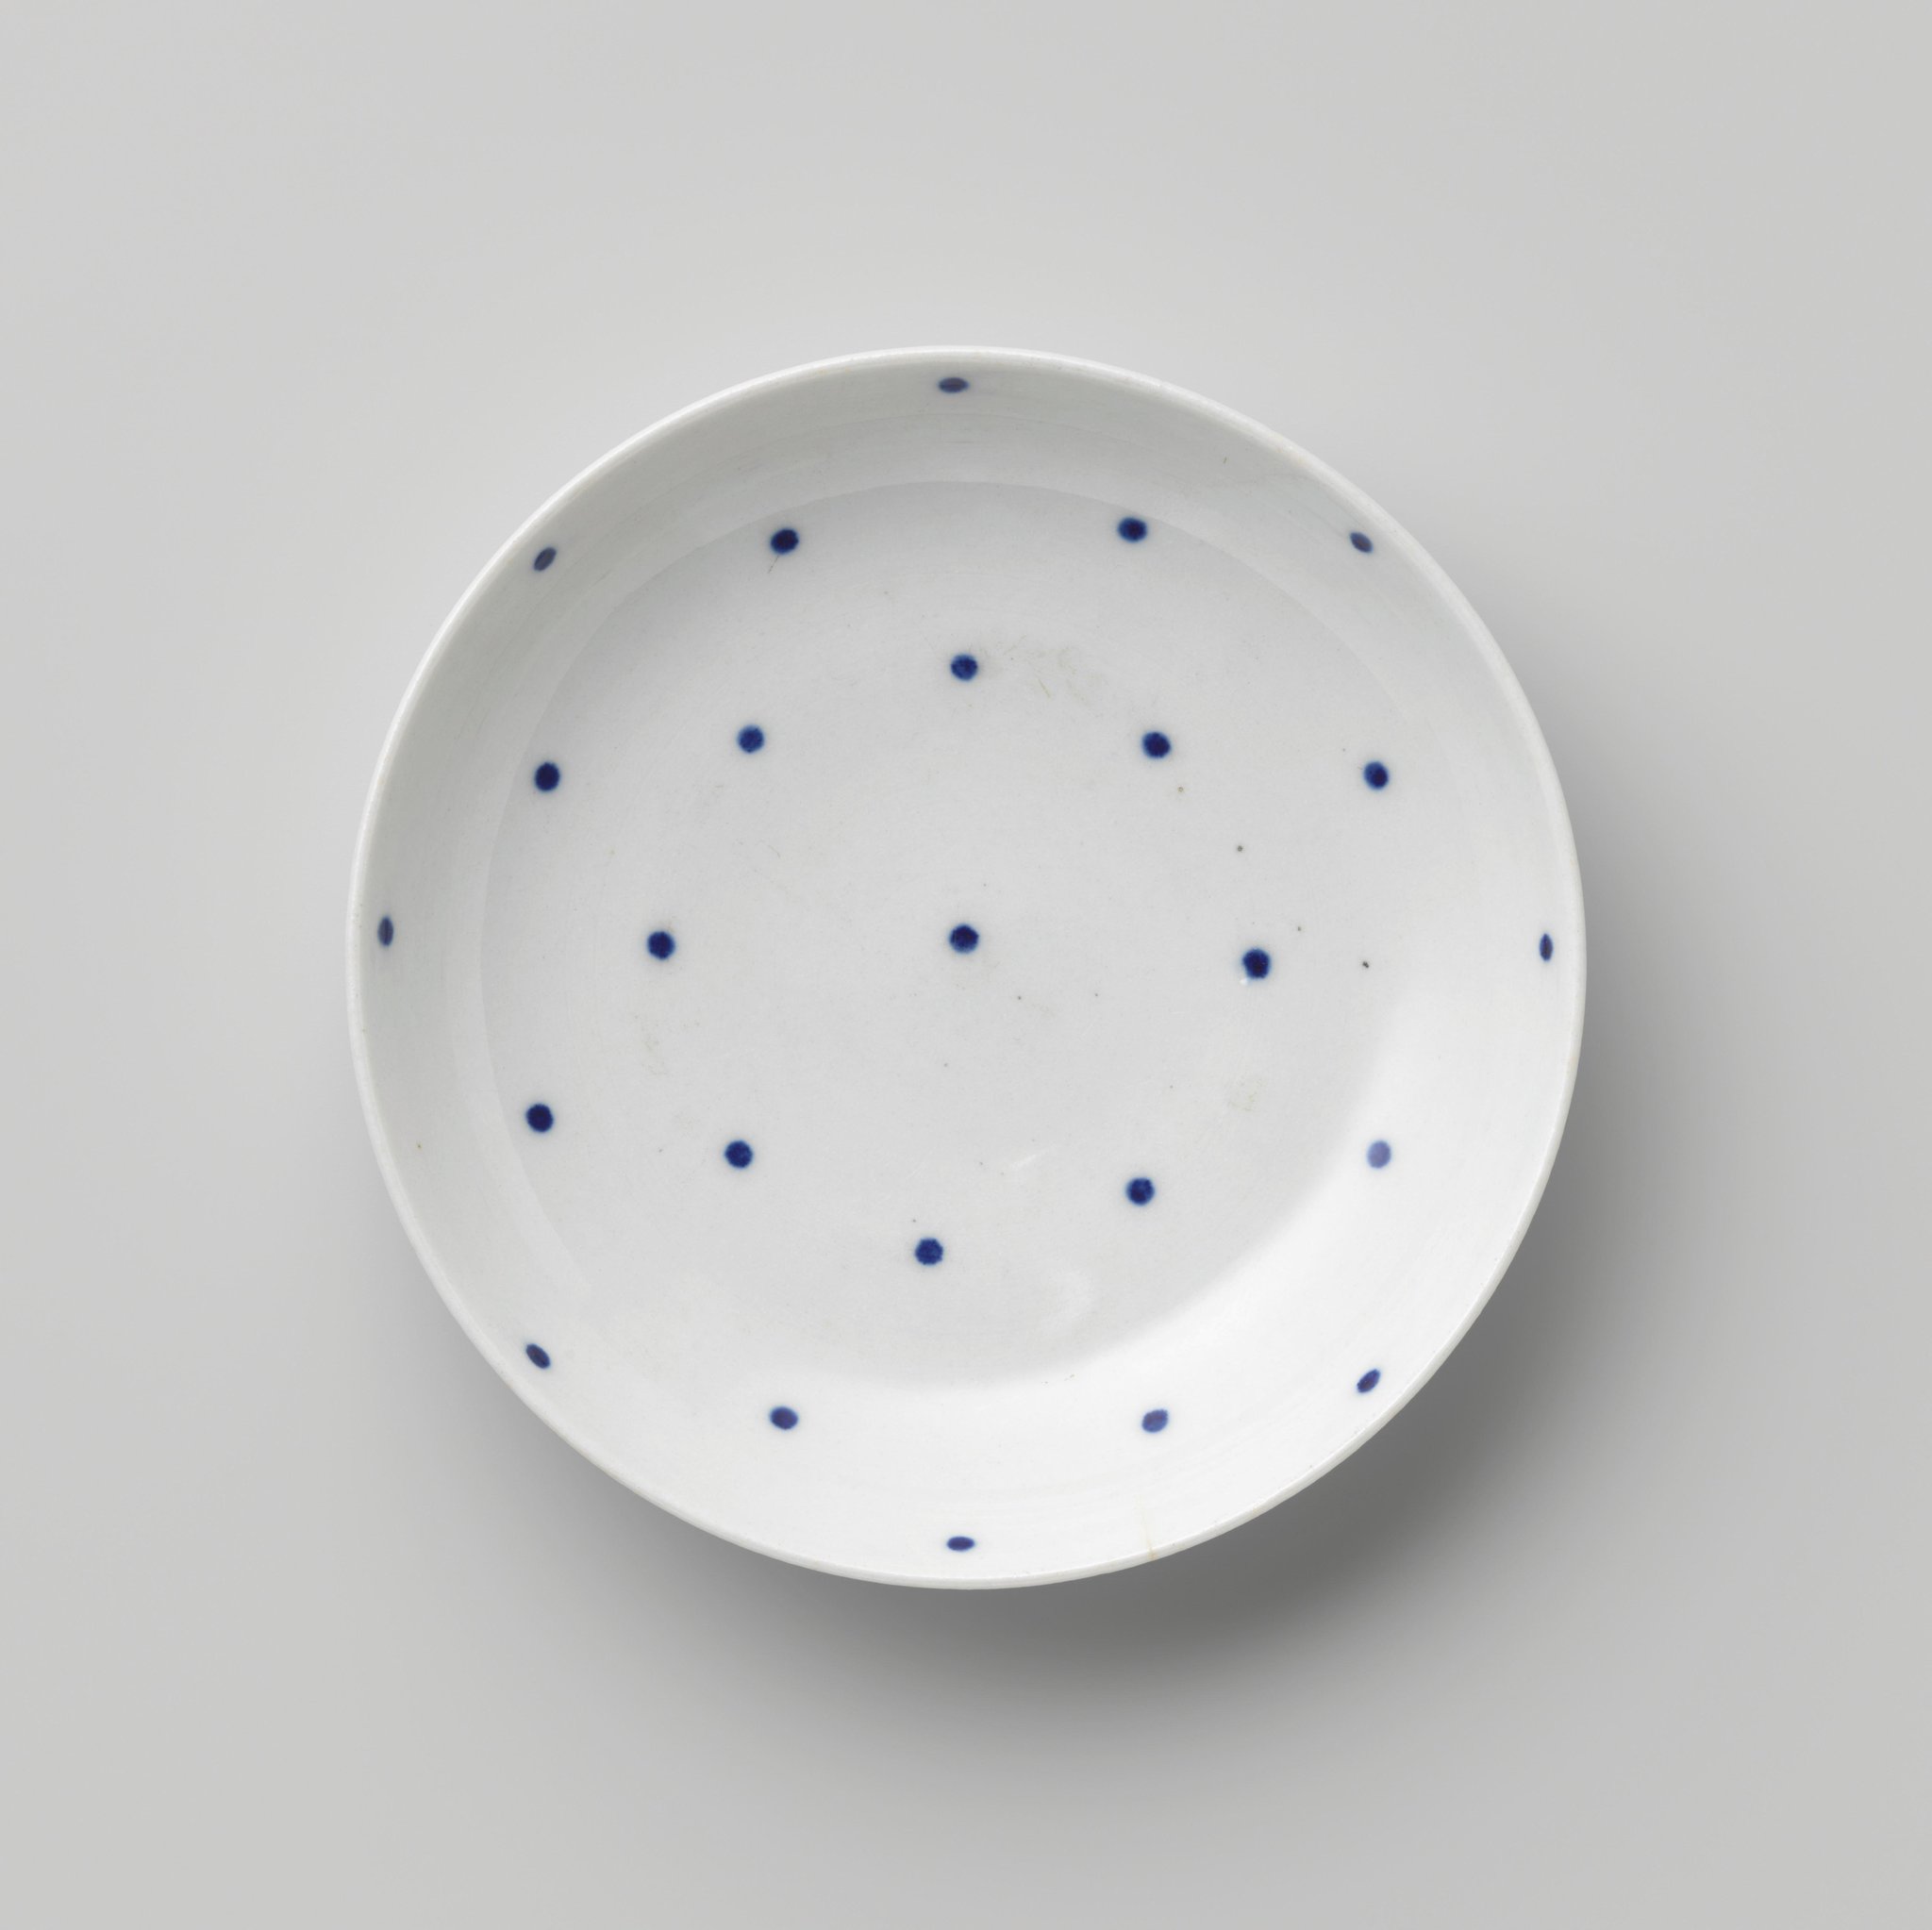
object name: platter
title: Schotel with blue dots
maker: Anonymous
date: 1775-1799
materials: cobalt, glaze, paint, porcelain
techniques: firing, turning, vitrification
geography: europe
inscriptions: mark: ‘3’, mark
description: Schotel van porselein, beschilderd in onderglazuur blauw. Het plat is versierd met stippen. Gemerkt op de onderzijde met een teken en een 3.